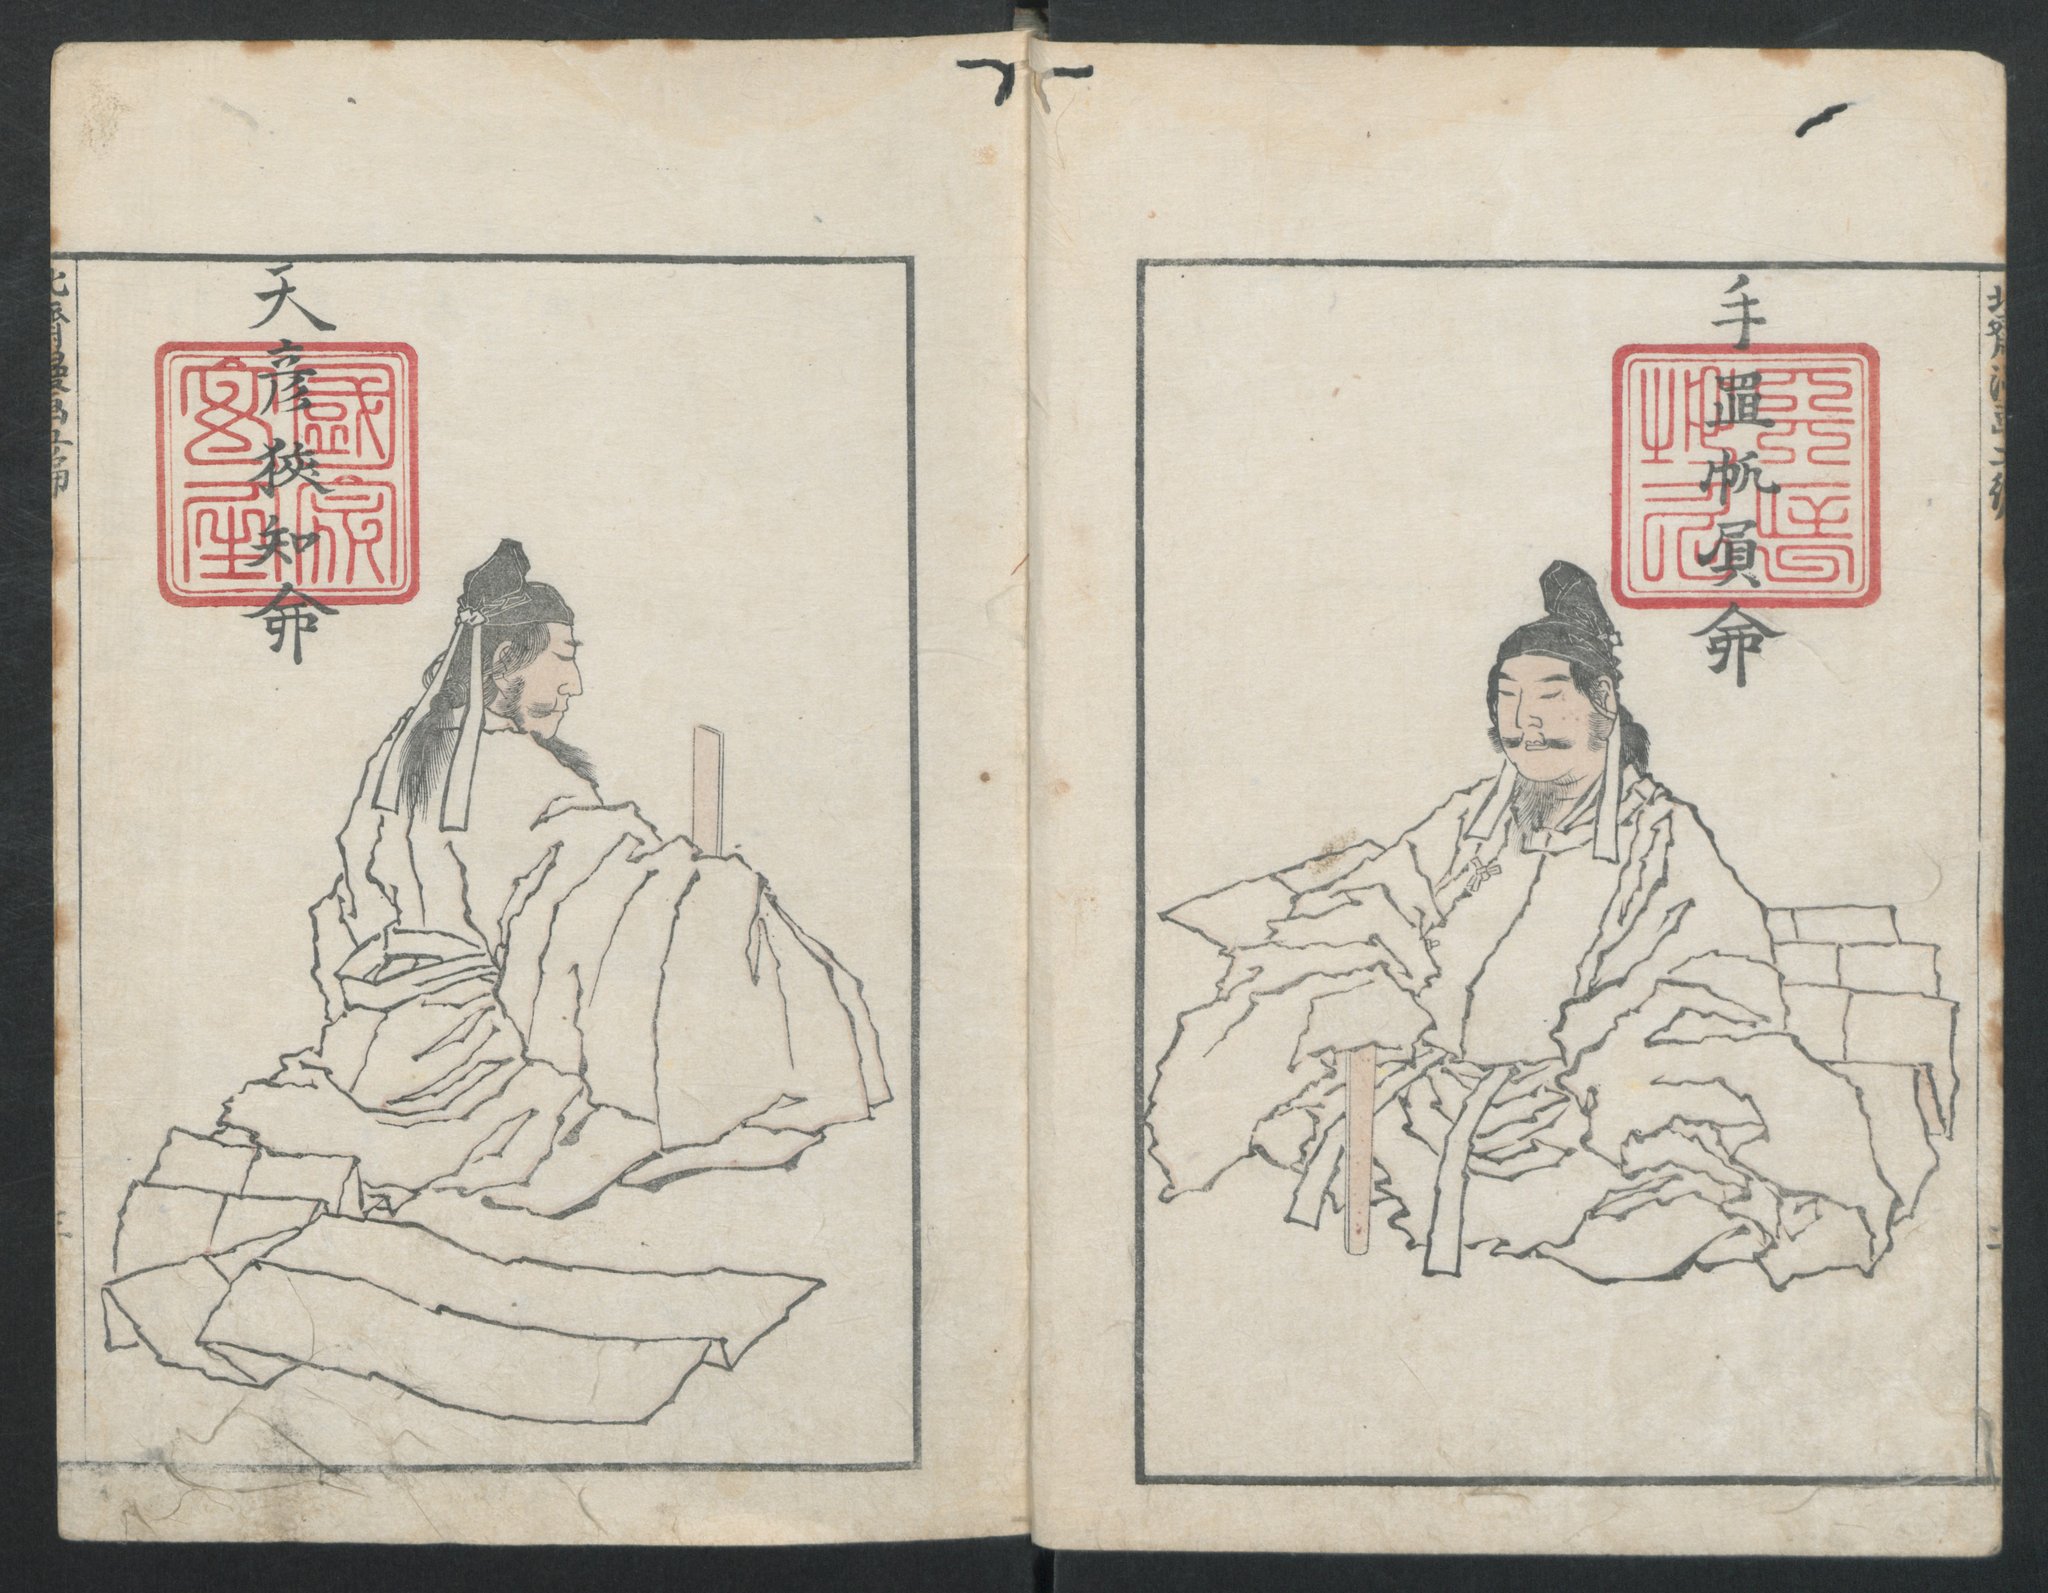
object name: illustrated book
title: Transmitting the Spirit, Revealing the Form of Things: Hokusai Sketchbooks (Denshin kaishu: Hokusai manga, gohen) 伝神開手 北斎漫画 五編: vol. 5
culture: japanese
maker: katsushika hokusai 葛飾北斎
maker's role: artist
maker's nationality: japanese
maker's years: 1760-1849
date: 1816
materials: ink, paper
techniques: woodblock print